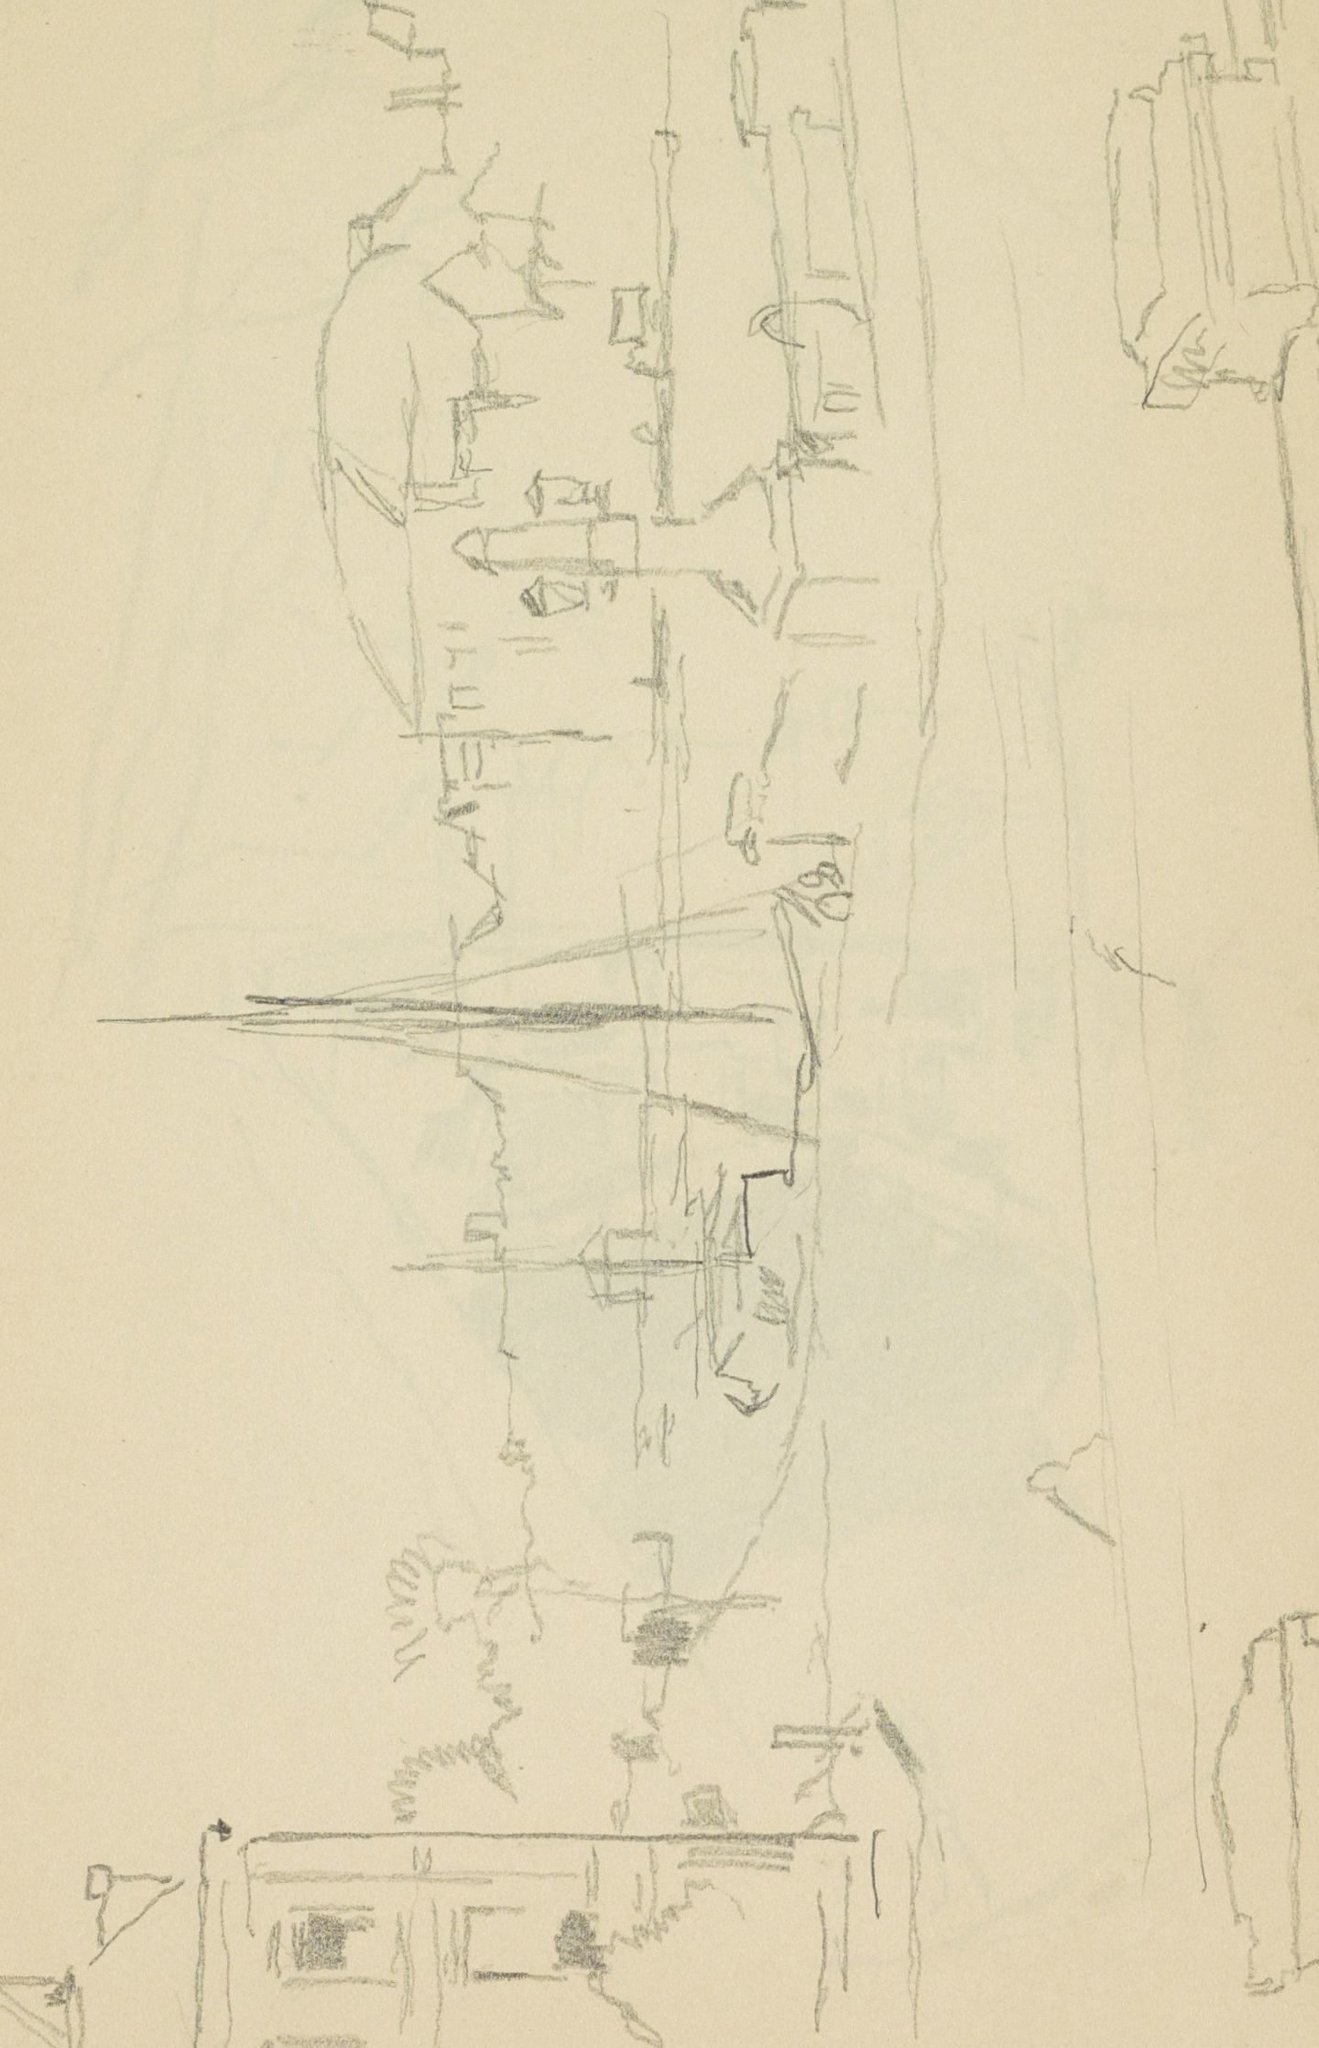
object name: sketchbook leaf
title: Straat aan een kanaal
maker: cornelis vreedenburgh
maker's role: draughtsman, print maker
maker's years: 1880-1946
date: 1890-1946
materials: paper, pencil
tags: canals, waters (in city), street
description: Aan de kade liggen zeilboten. Over het kanaal een brug. Blad 12 recto uit een schetsboek met 73 bladen.